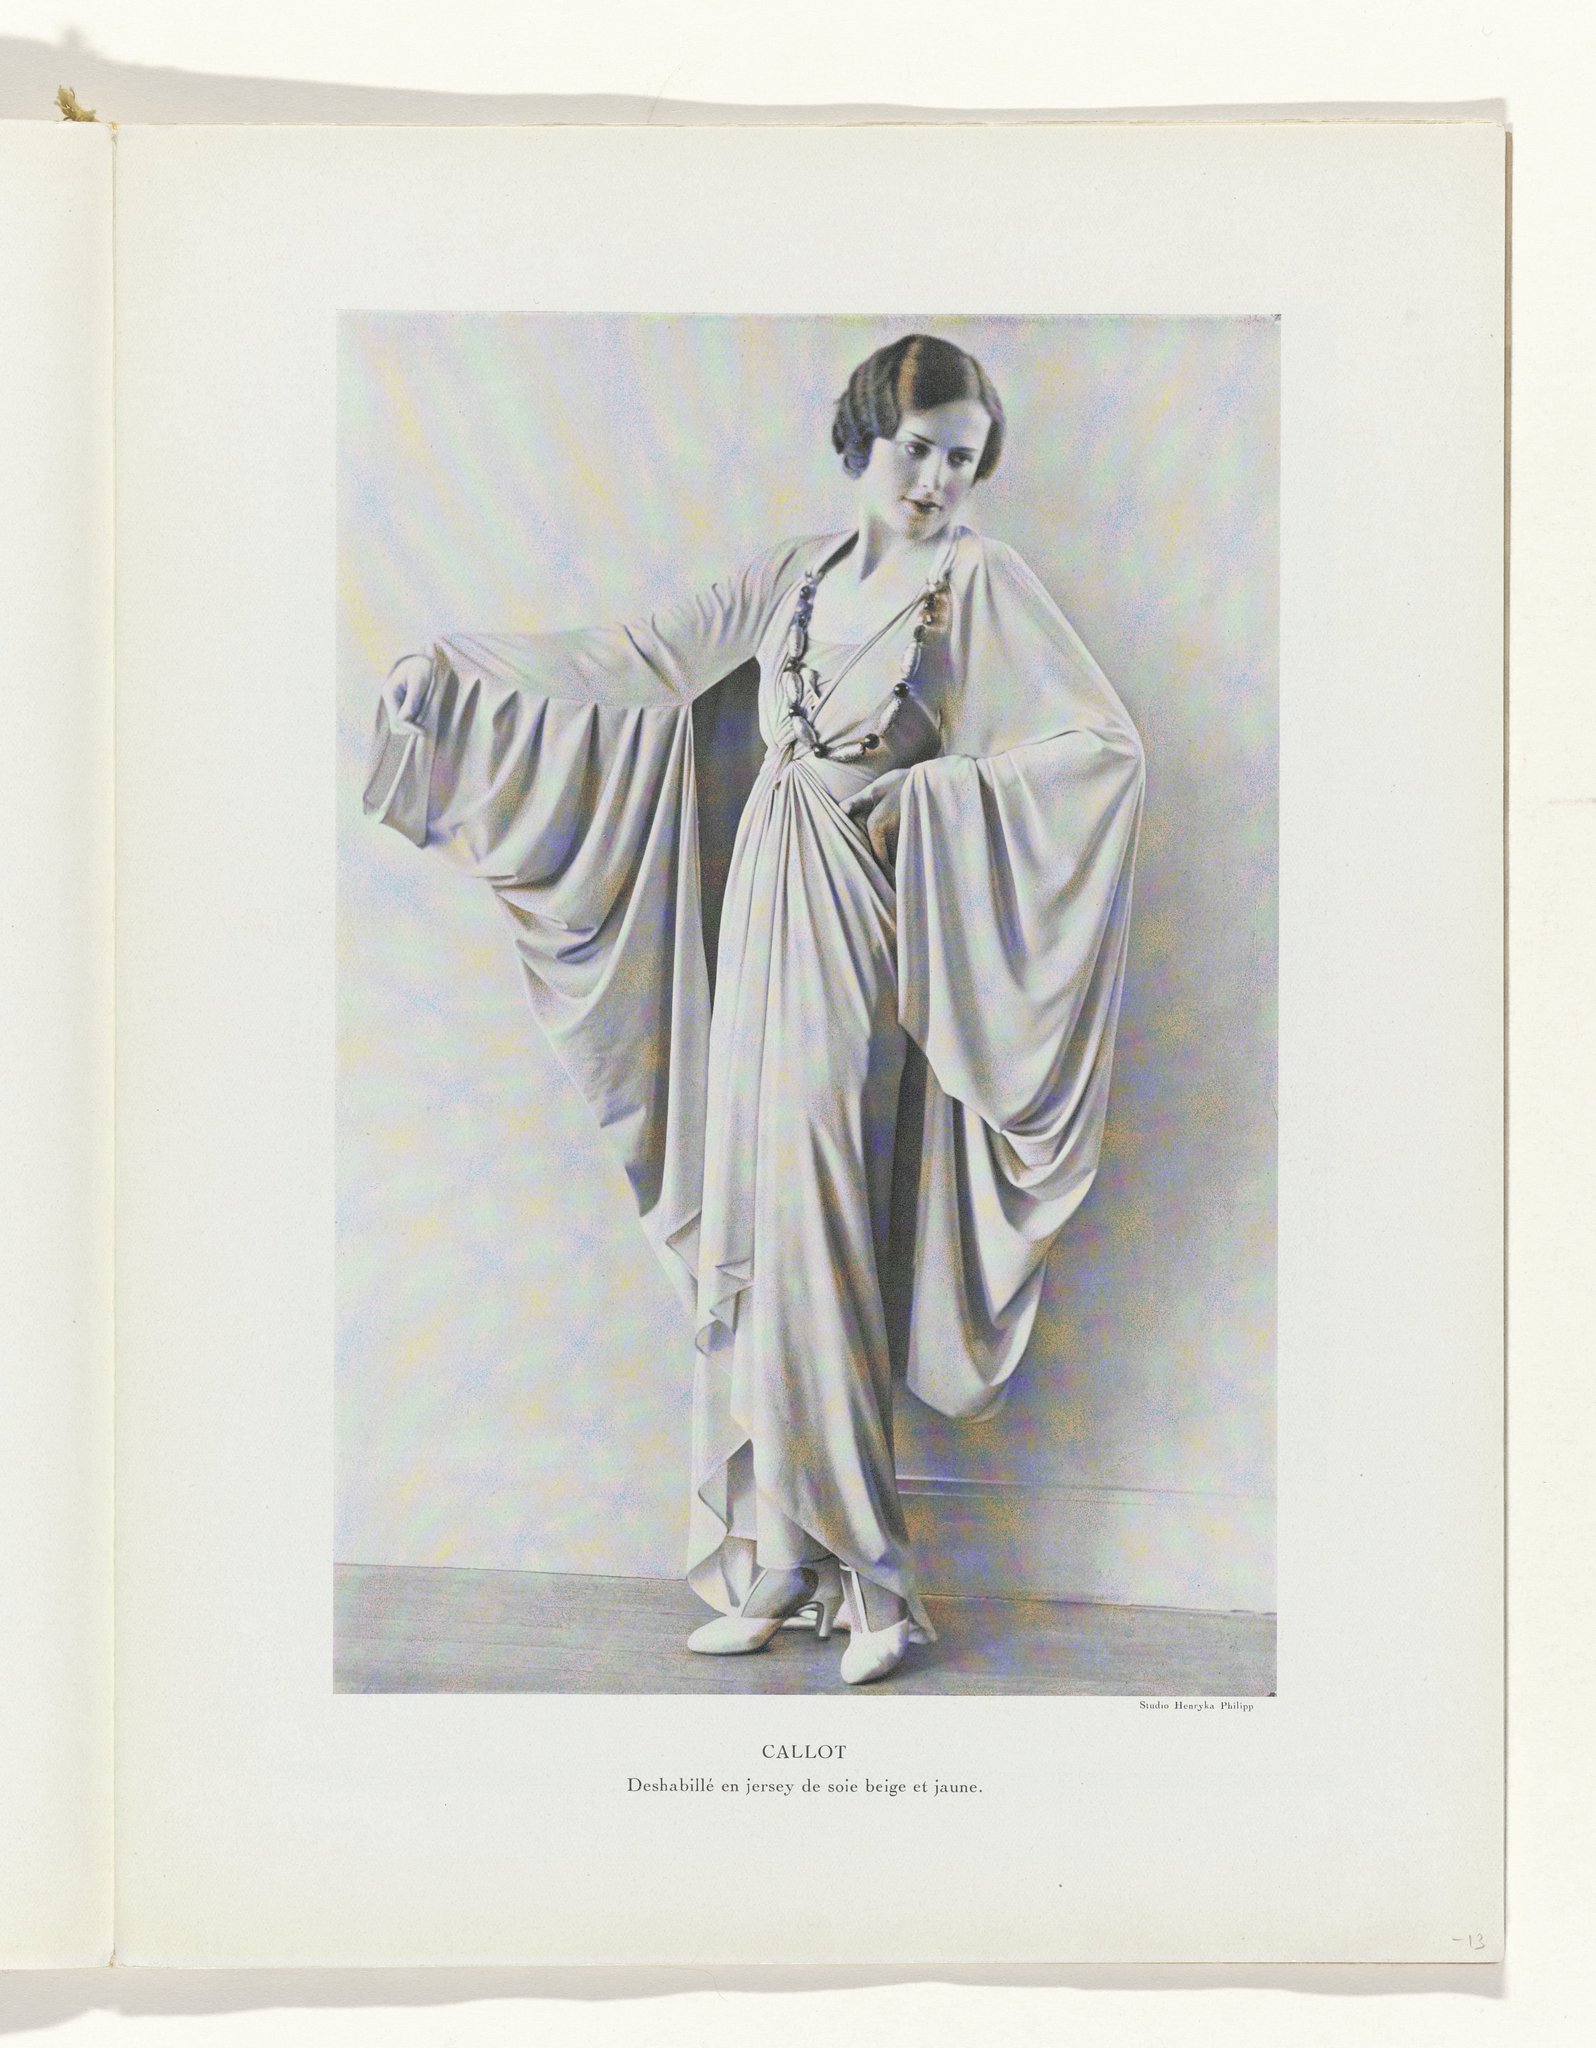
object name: magazine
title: Art - Goût - Beauté, Feuillets de l' élégance féminine, Juin 1932, No. 142, 12e Année, p. 13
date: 1932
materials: paper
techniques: photography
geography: paris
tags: cape (+ women's clothes), fashion plates, shoes, sandals (+ women's clothes), dress, gown (+ women's clothes), necklace (+ women's clothes)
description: 'Deshabillé van zijde jersey in beige en geel, van Callot. Pagina uit het modetijdschrift Art-Goût-Beauté (1920-1933).